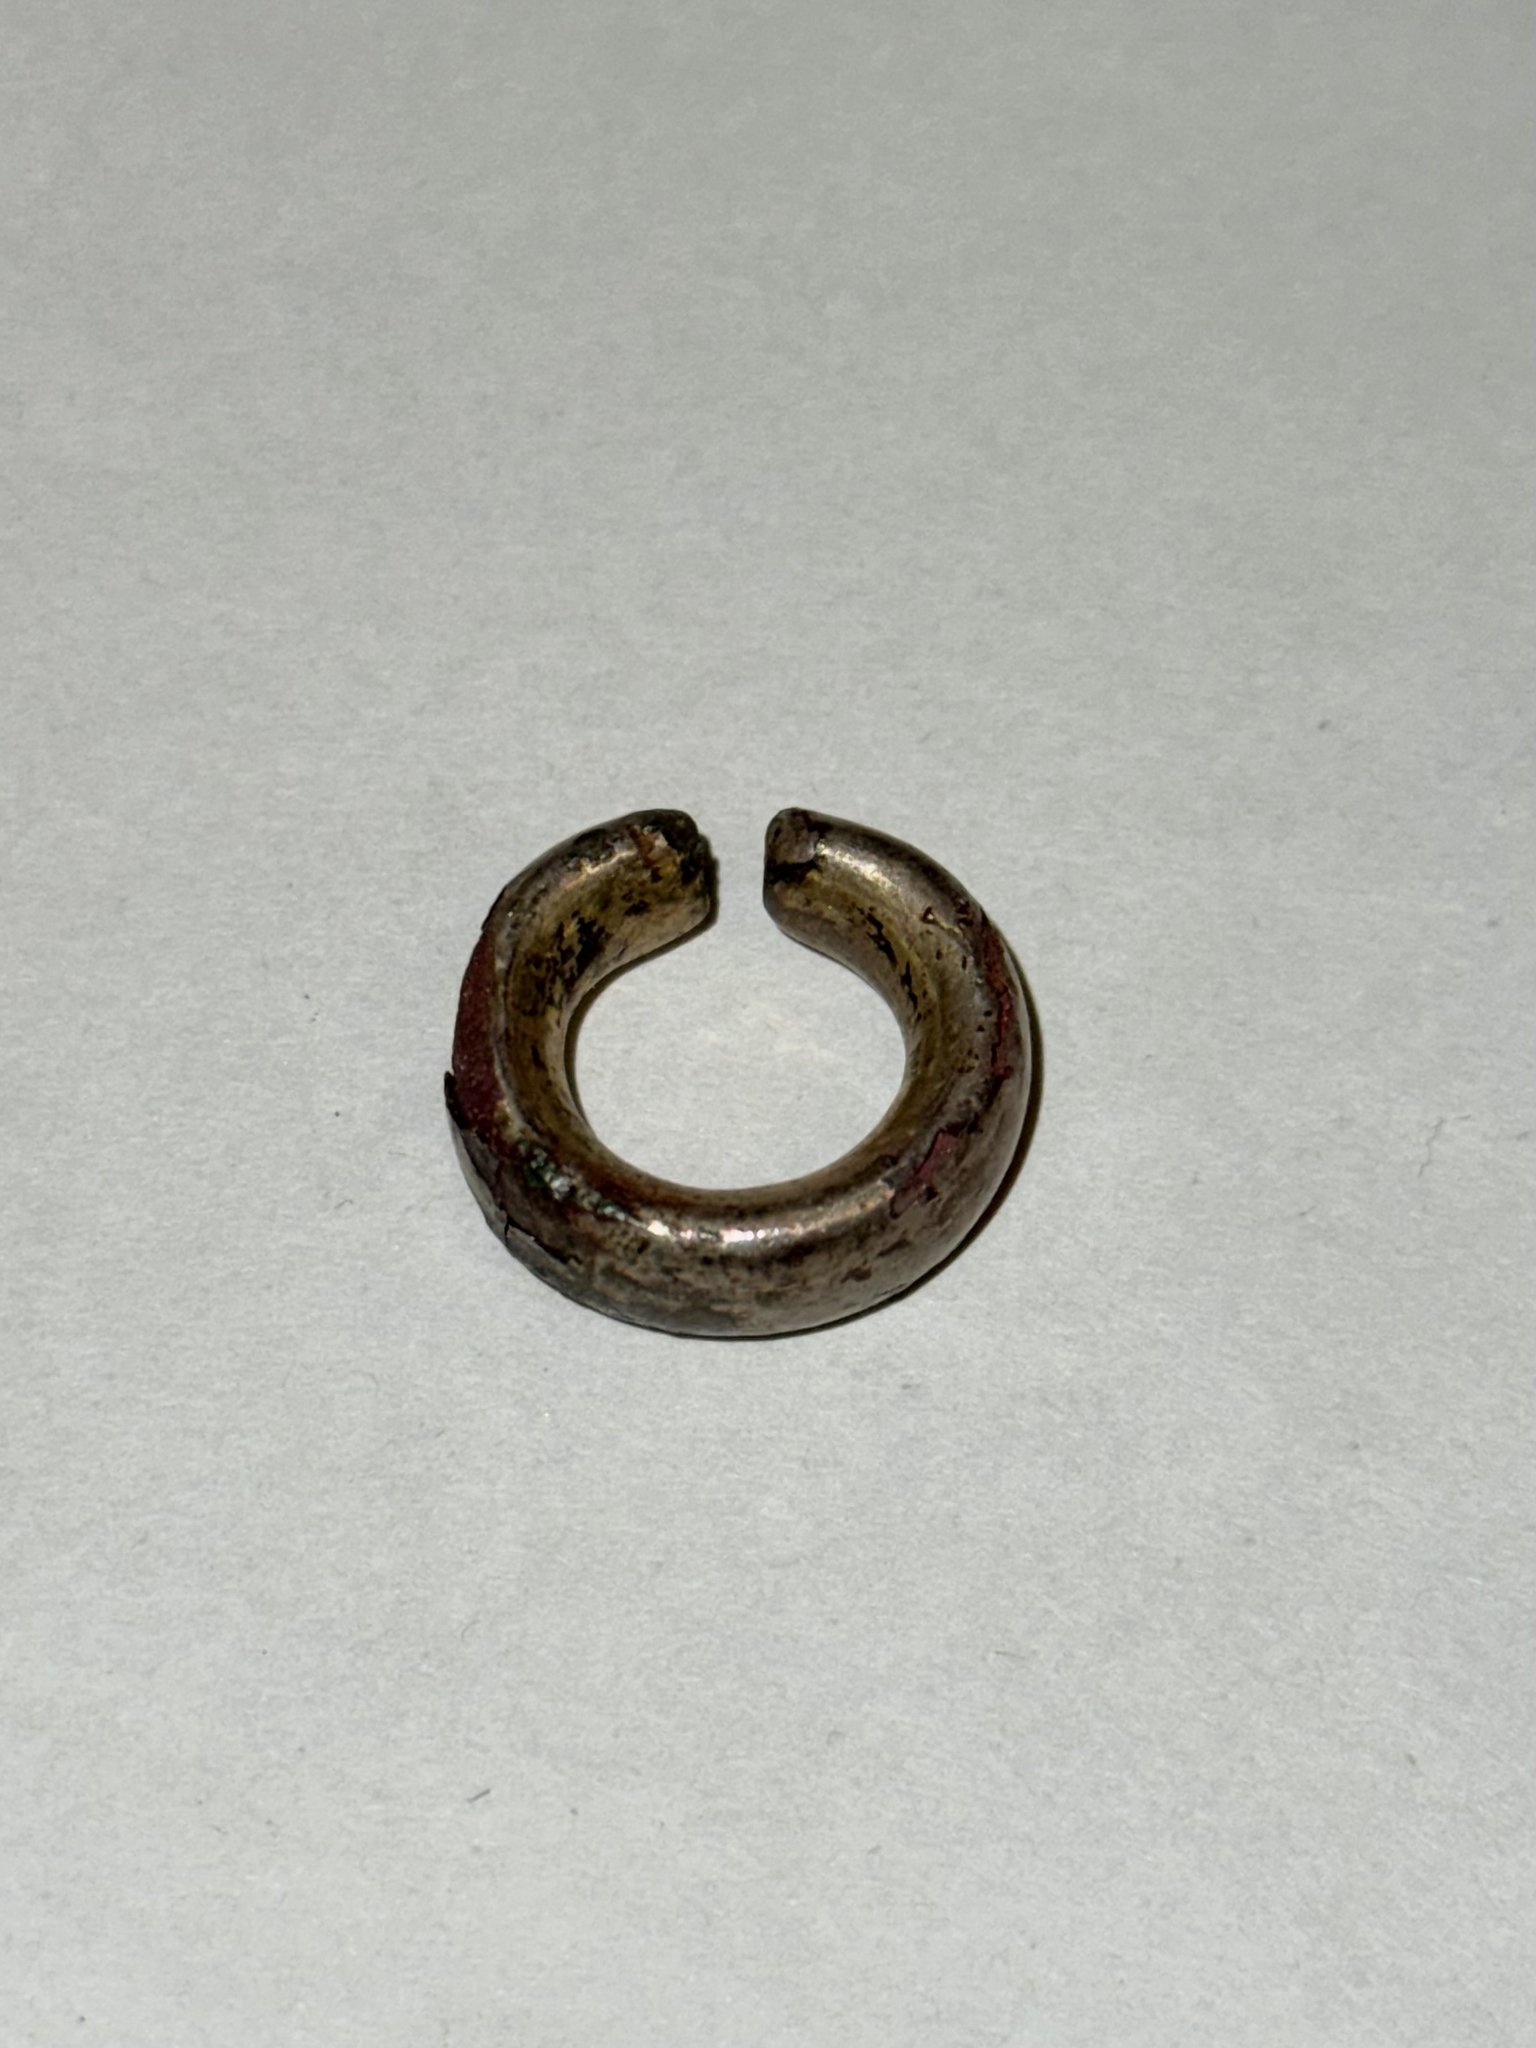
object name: earring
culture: japanese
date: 601-700